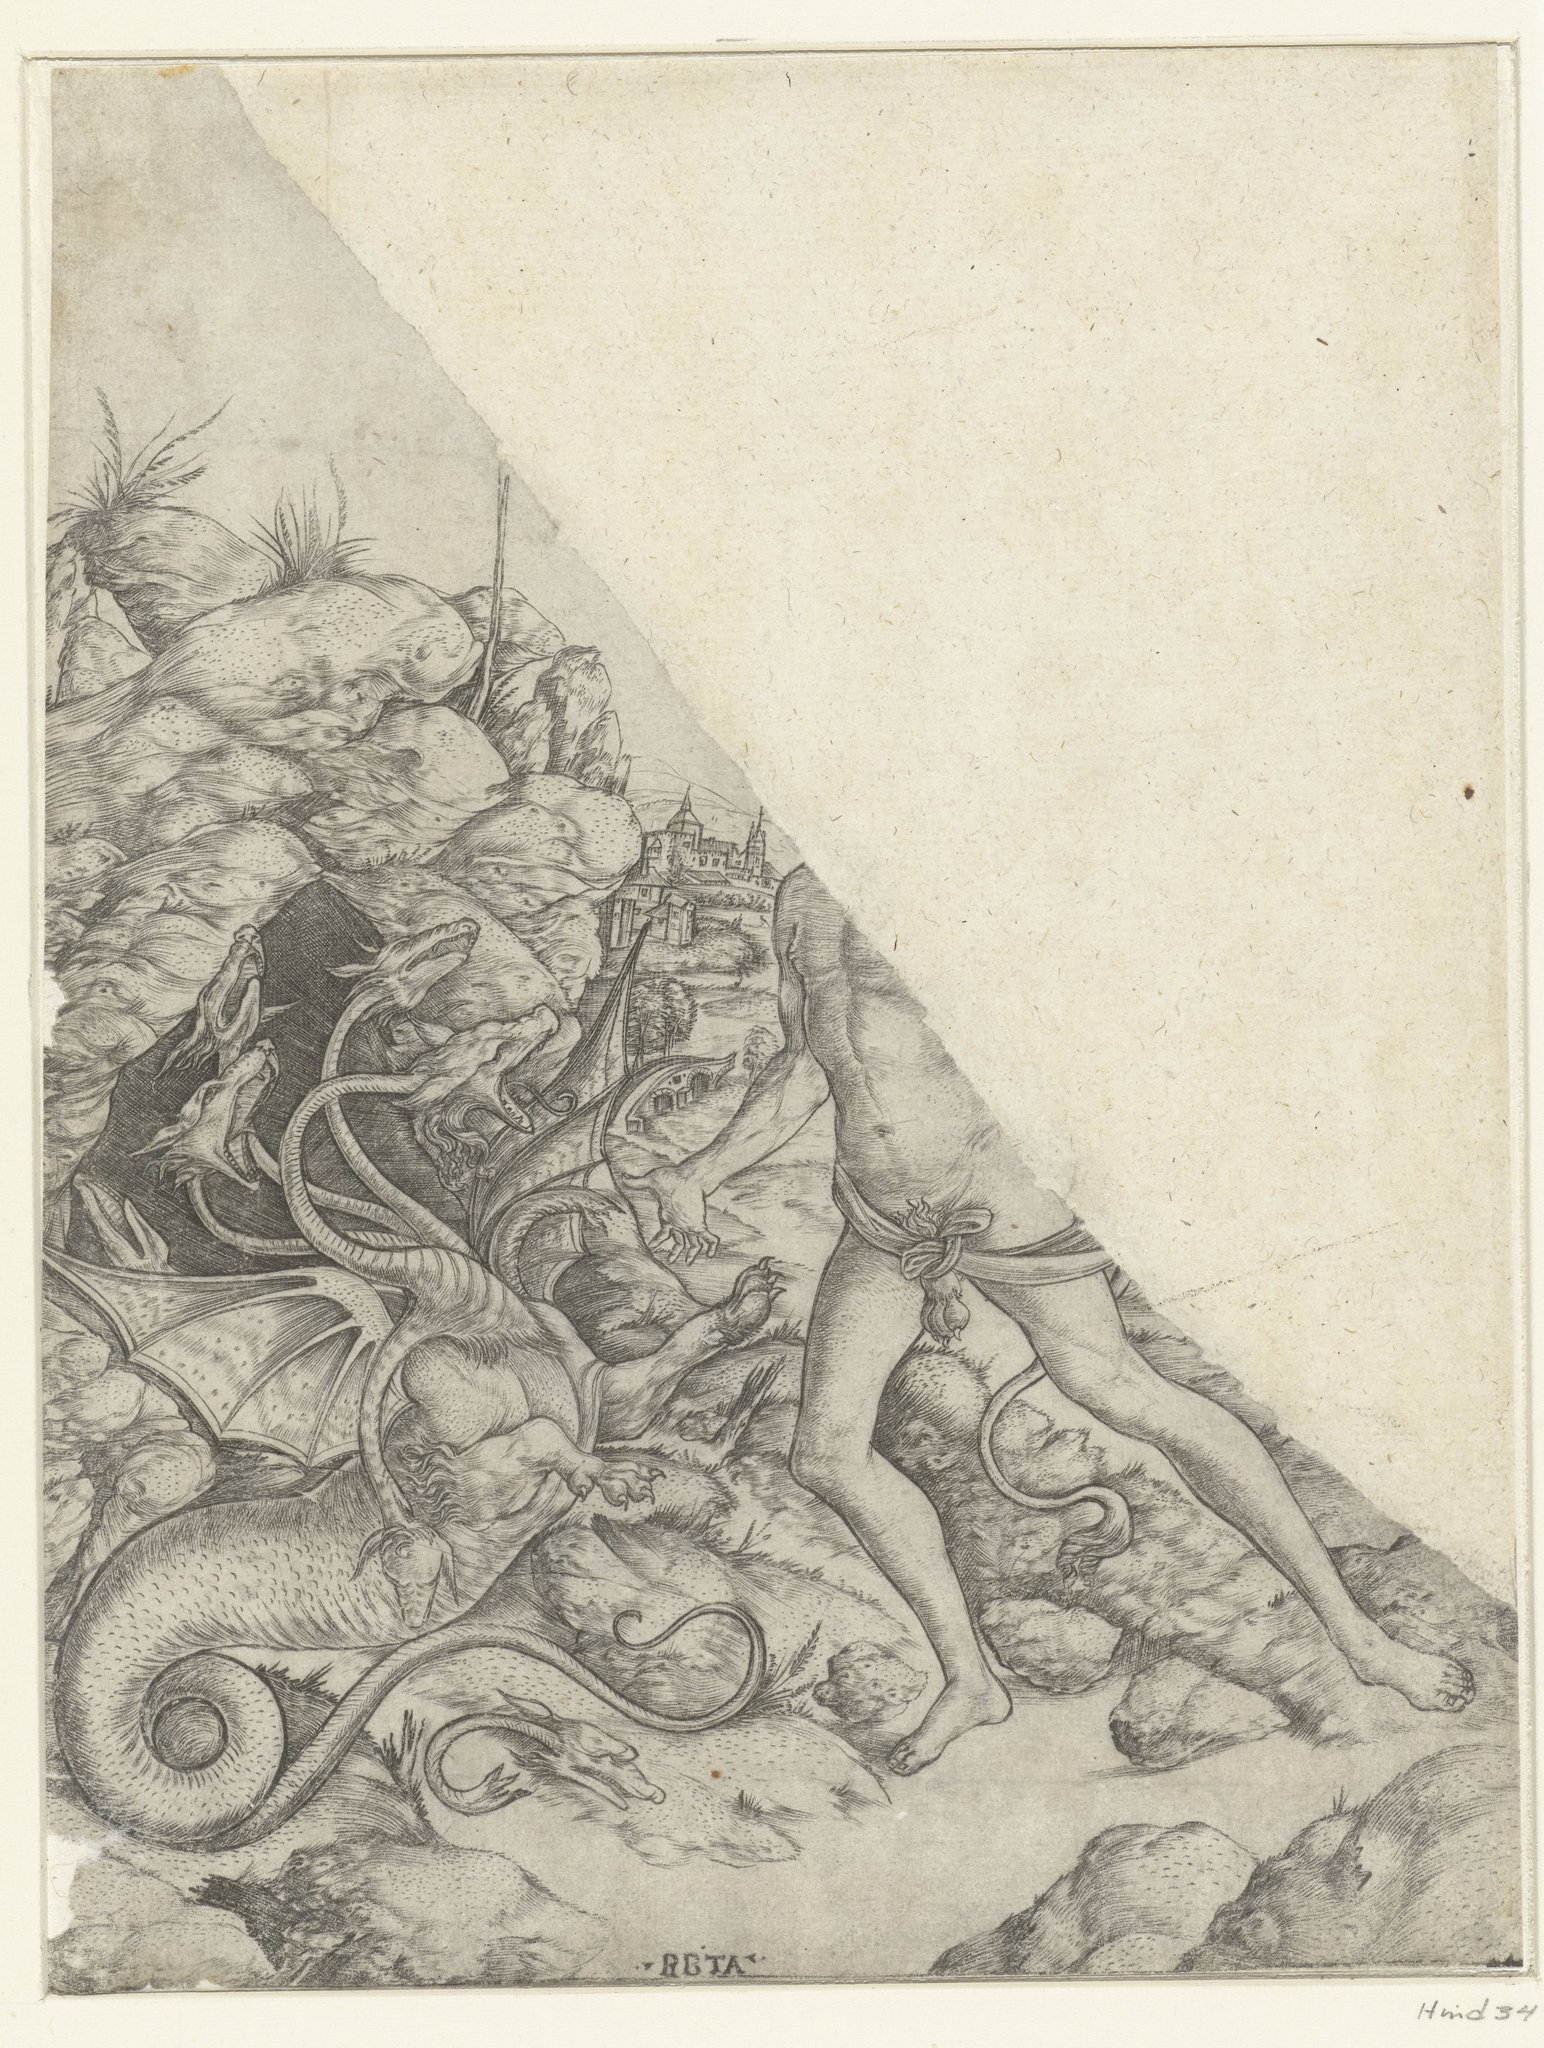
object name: print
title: Fragment met Hercules verslaat de Hydra van Lerna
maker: christoforo di michele robetta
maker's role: print maker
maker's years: 1462-1522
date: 1480-1535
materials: paper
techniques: engraving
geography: italy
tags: (2) the hydra of lerna is killed by hercules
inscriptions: collector's mark: Lugt 11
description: De figuur van hercules en de hydra zijn ontleent aan een schilderij van Antonio Pollaiuolo (Uffizi, Florence). Het landschap is Robetta's eigen inventie.